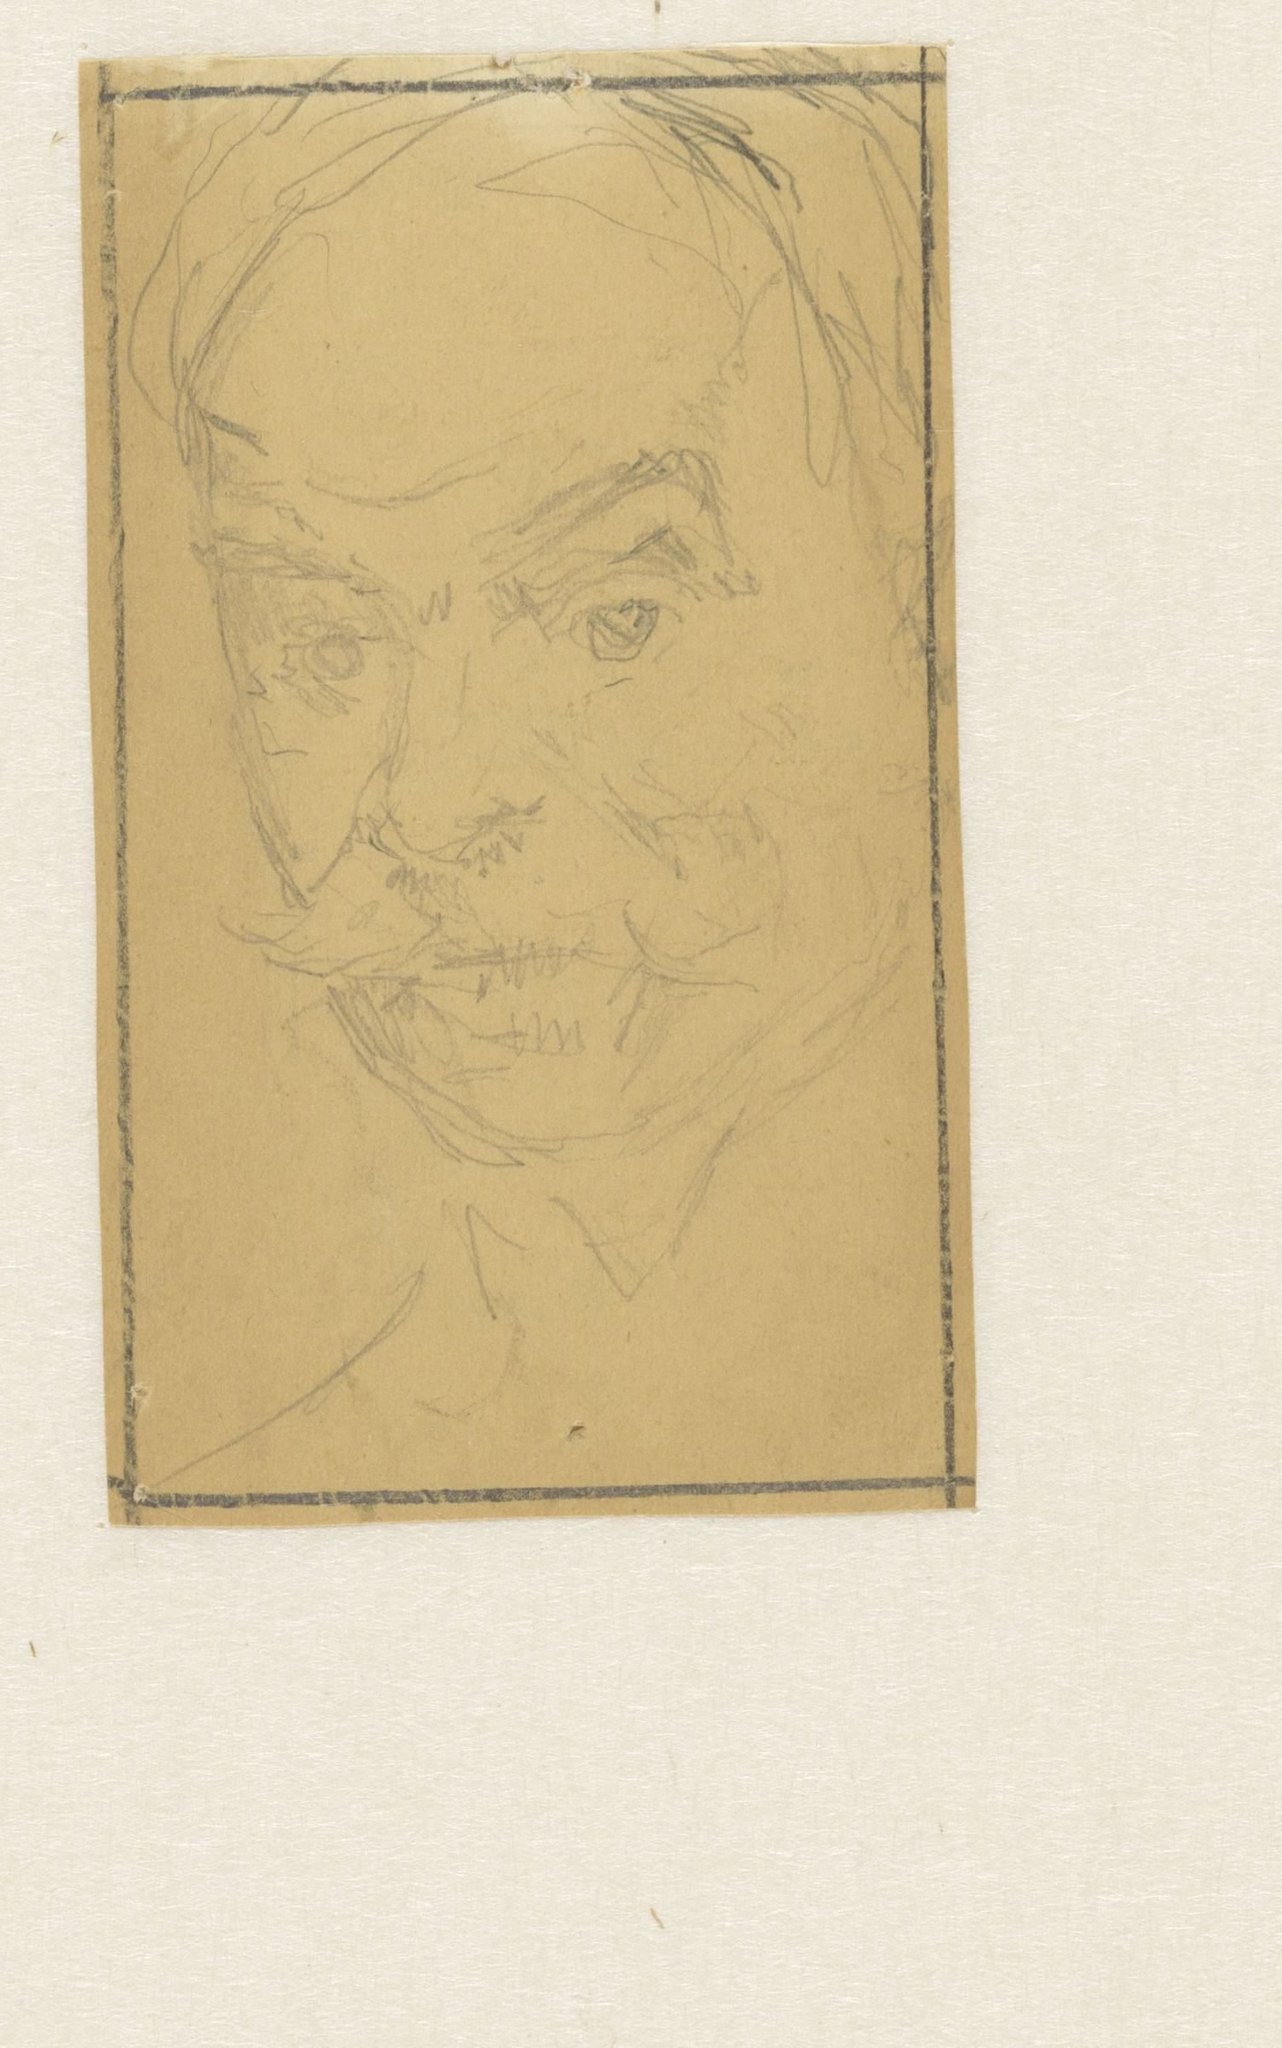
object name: drawing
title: Mansportret, Hofstede de Groot (?)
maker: jan veth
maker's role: designer, draughtsman, painter, print maker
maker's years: 1864-1925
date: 1874-1925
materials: paper, pencil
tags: the hague, cornelis hofstede de groot, anonymous historical person portrayed alone, historical persons